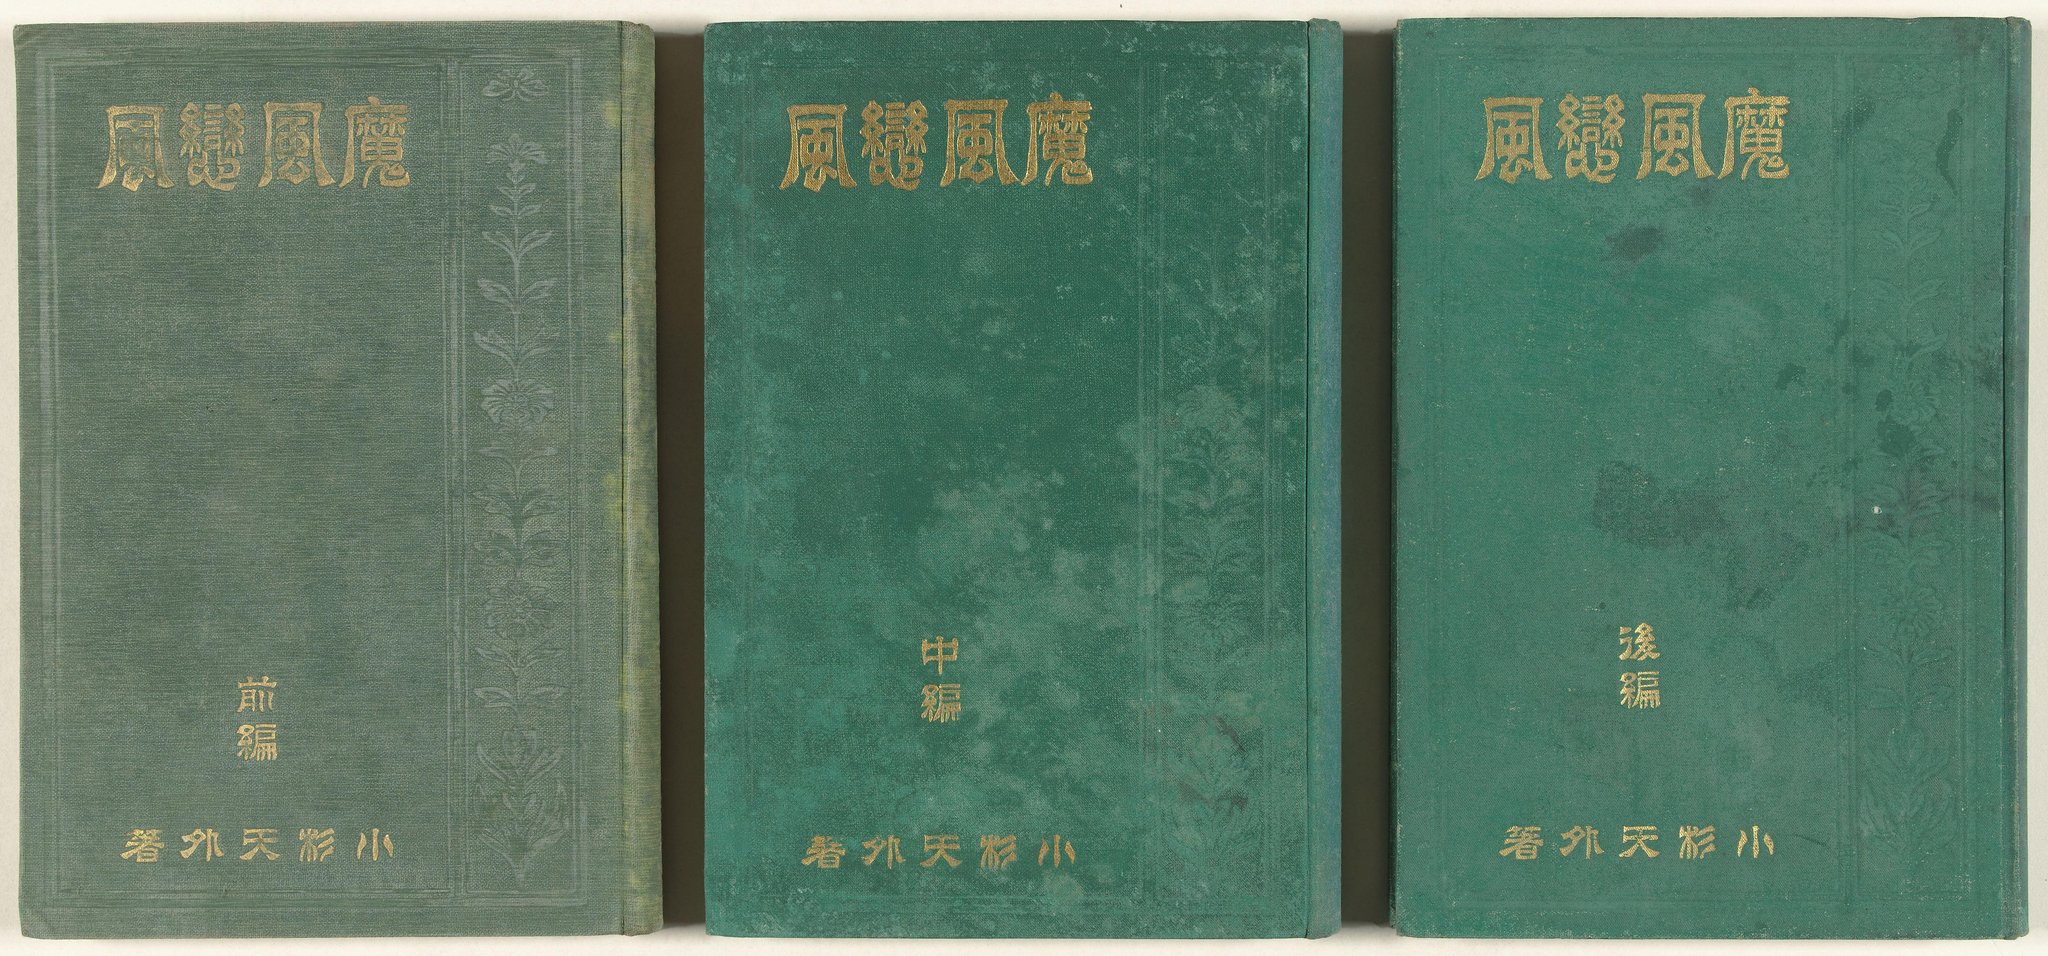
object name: book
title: Kwaadaardige wind, liefdevolle wind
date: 1908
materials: paper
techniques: woodcut, letterpress printing, lithograph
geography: japan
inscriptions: date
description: Roman in drie delen (compleet), met in elk deel een uitvouwbare frontispies.